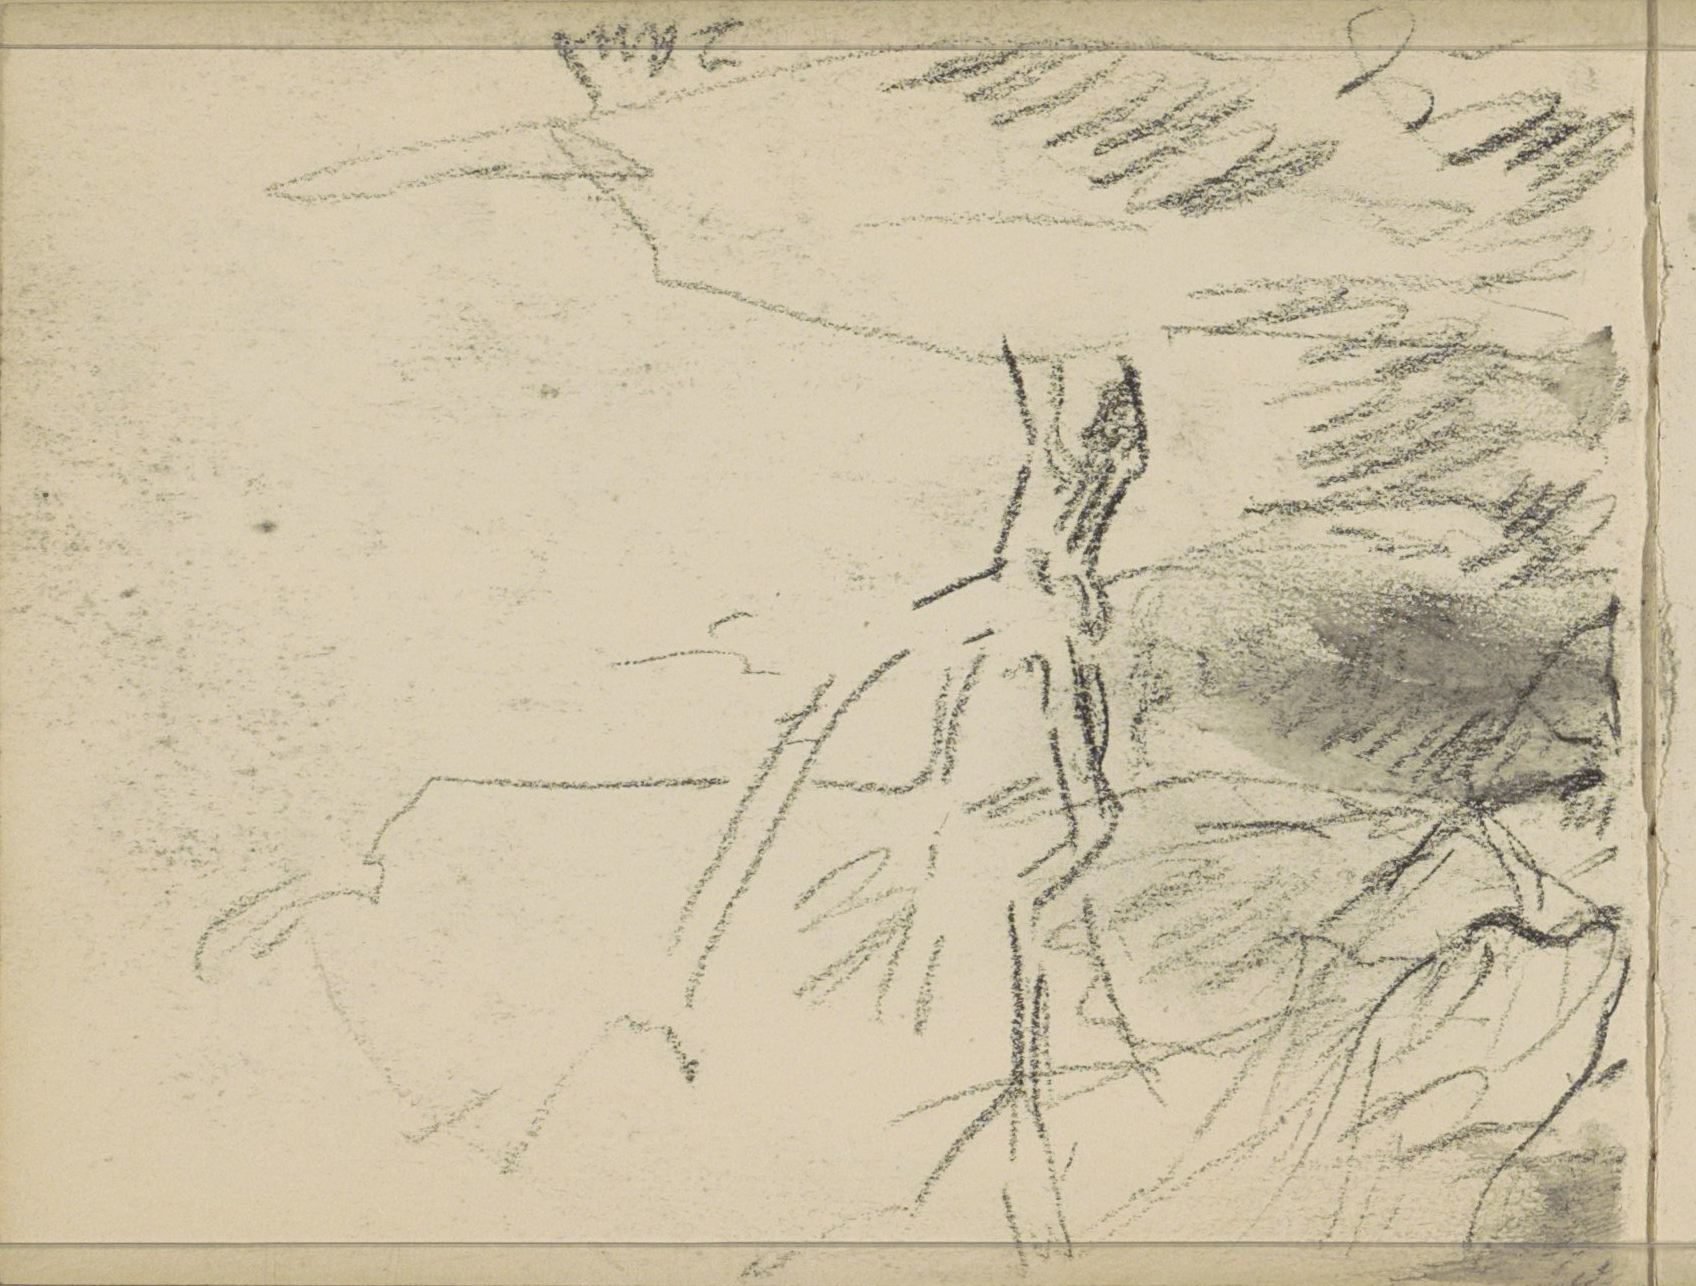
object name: sketchbook leaf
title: Landschap, mogelijk een duinlandschap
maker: johan antonie de jonge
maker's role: draughtsman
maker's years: 1864-1927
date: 1881-1927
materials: chalk, paper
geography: south holland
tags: dunes (sea not visible); in the dunes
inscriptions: annotation: ‘zand’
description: Landschap, mogelijk een duinlandschap. Blad 19 verso uit een schetsboek met 34 bladen.